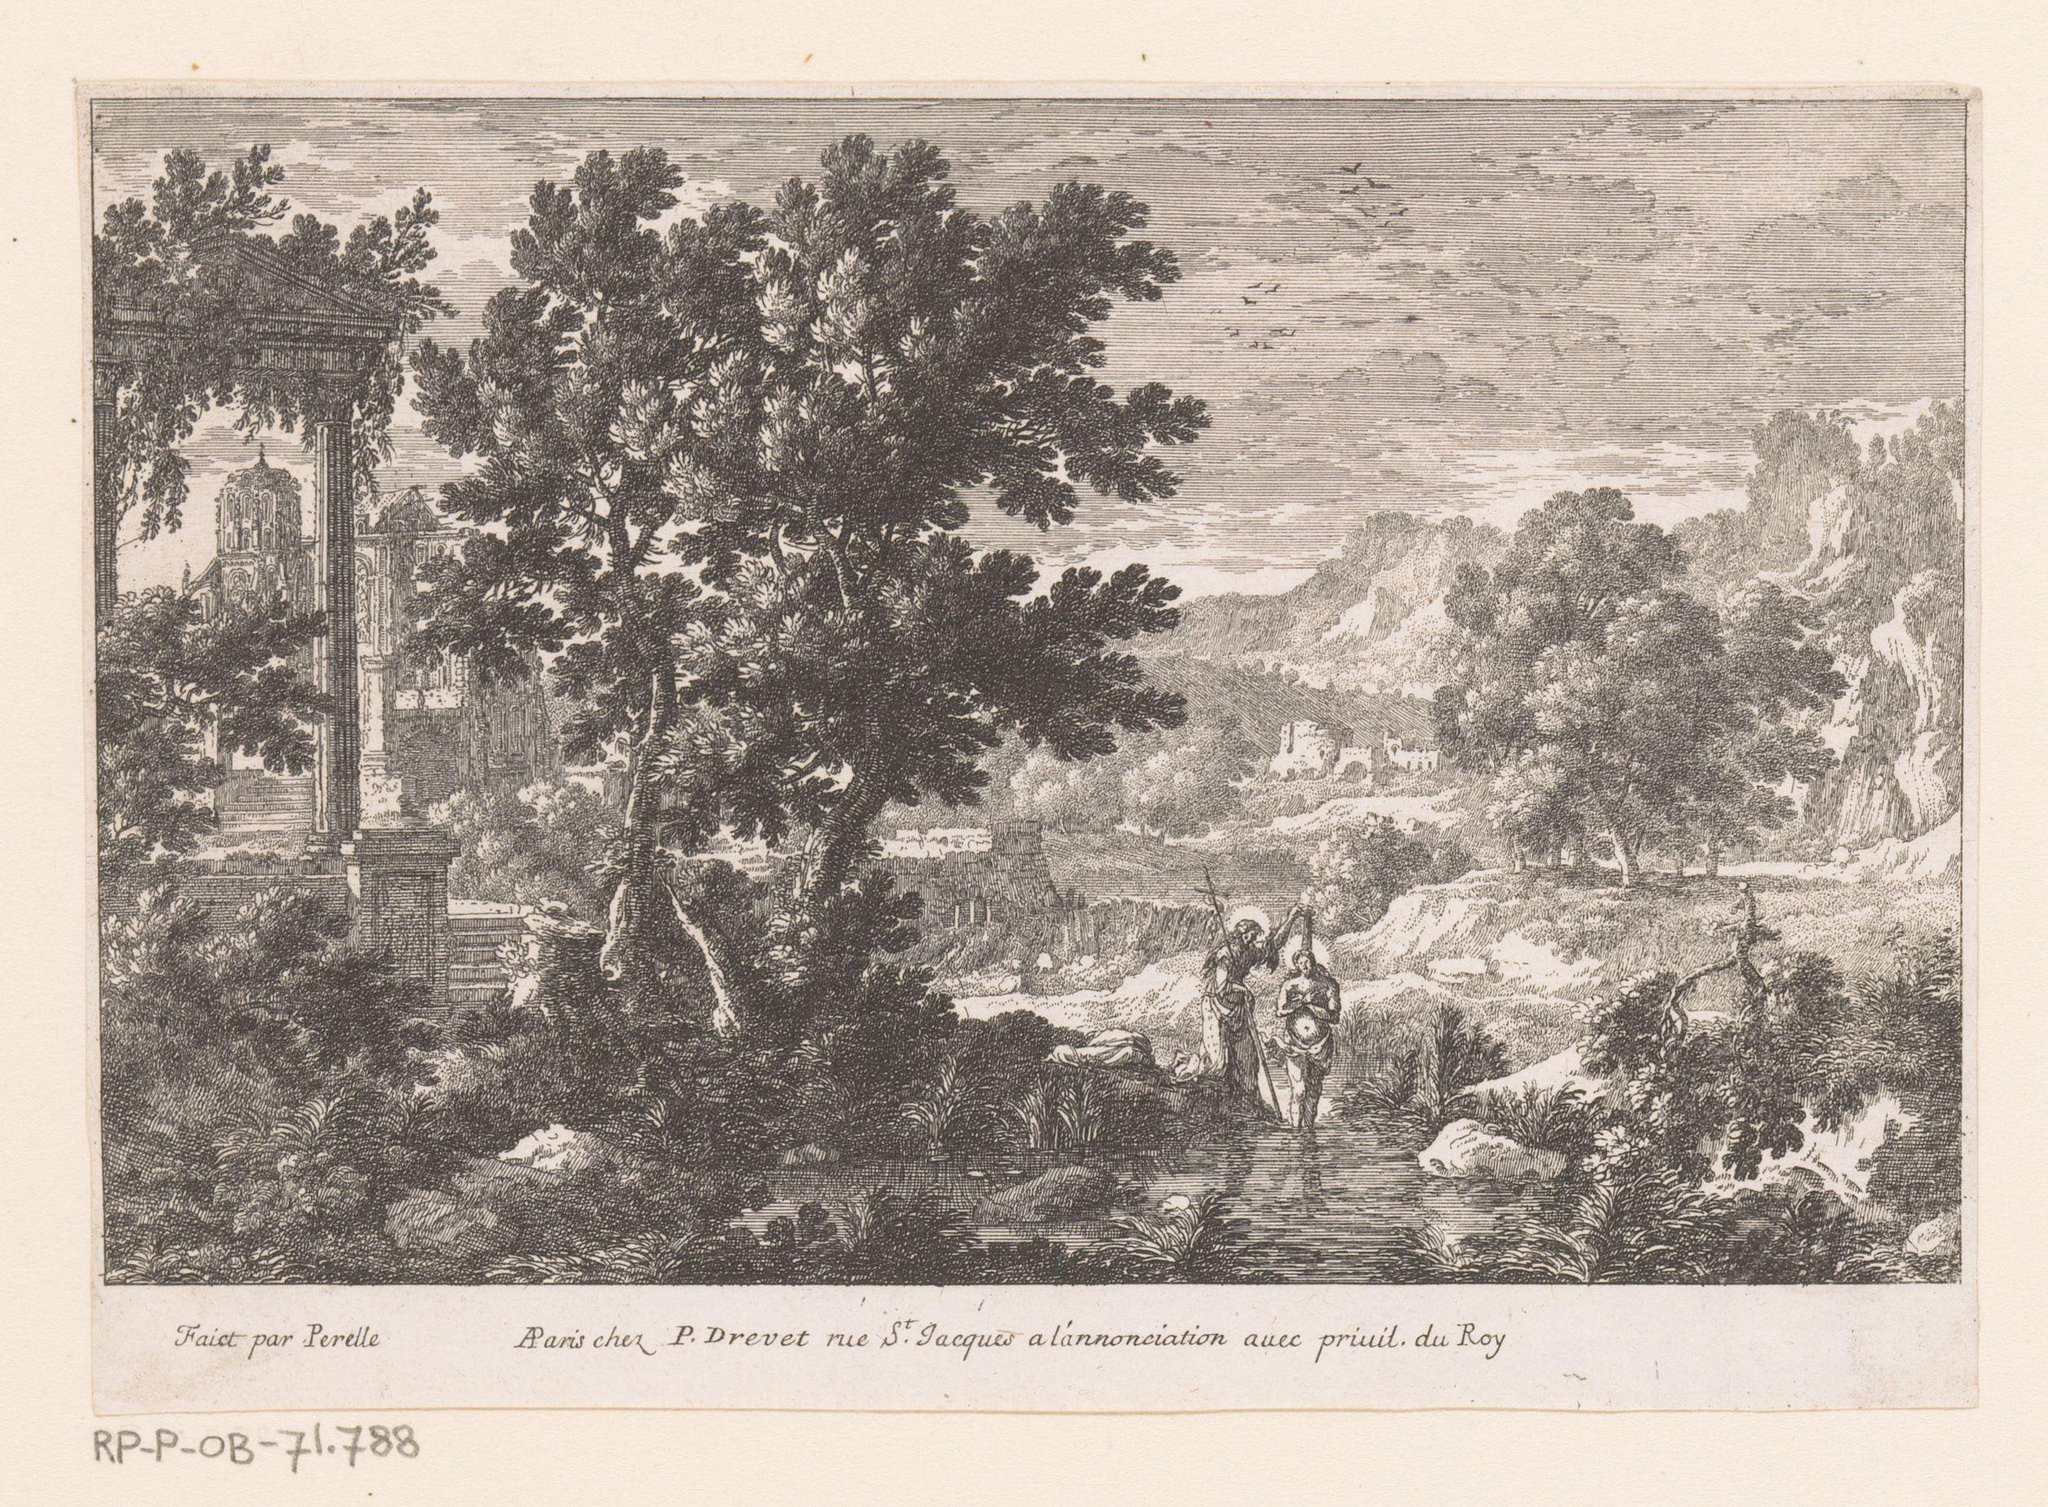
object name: print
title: Landschap met de doop van Christus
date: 1673-1695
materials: paper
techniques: etching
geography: france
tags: baptism of christ in the river jordan: john the baptist pouring out water on christ's head: the holy ghost descends, landscapes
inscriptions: collector's mark: Lugt 240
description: Prent maakt deel uit van een ongenummerde serie van zes prenten.